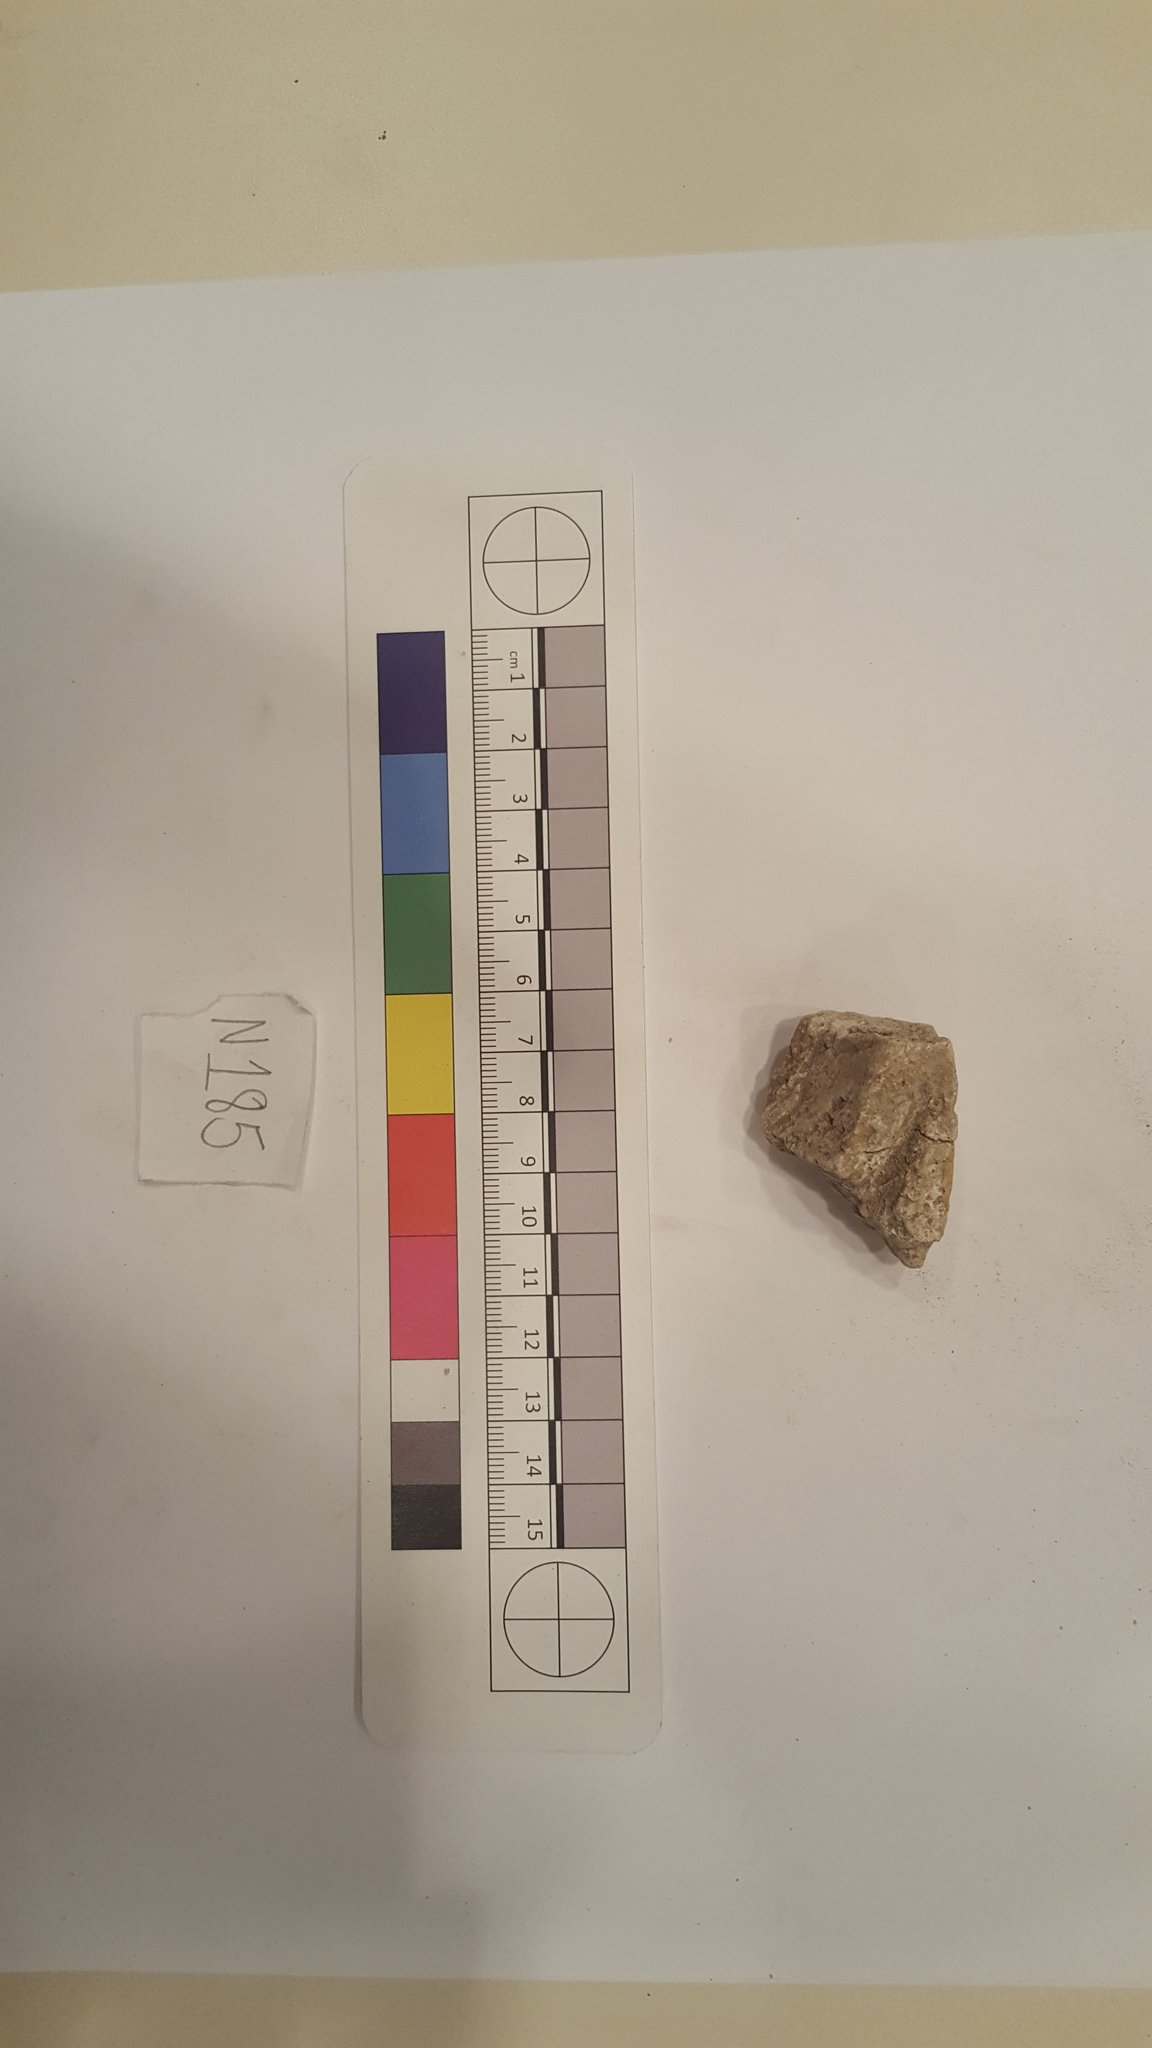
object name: fragment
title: Stucco Fragment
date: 701-1200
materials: plaster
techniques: carving, painting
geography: iran